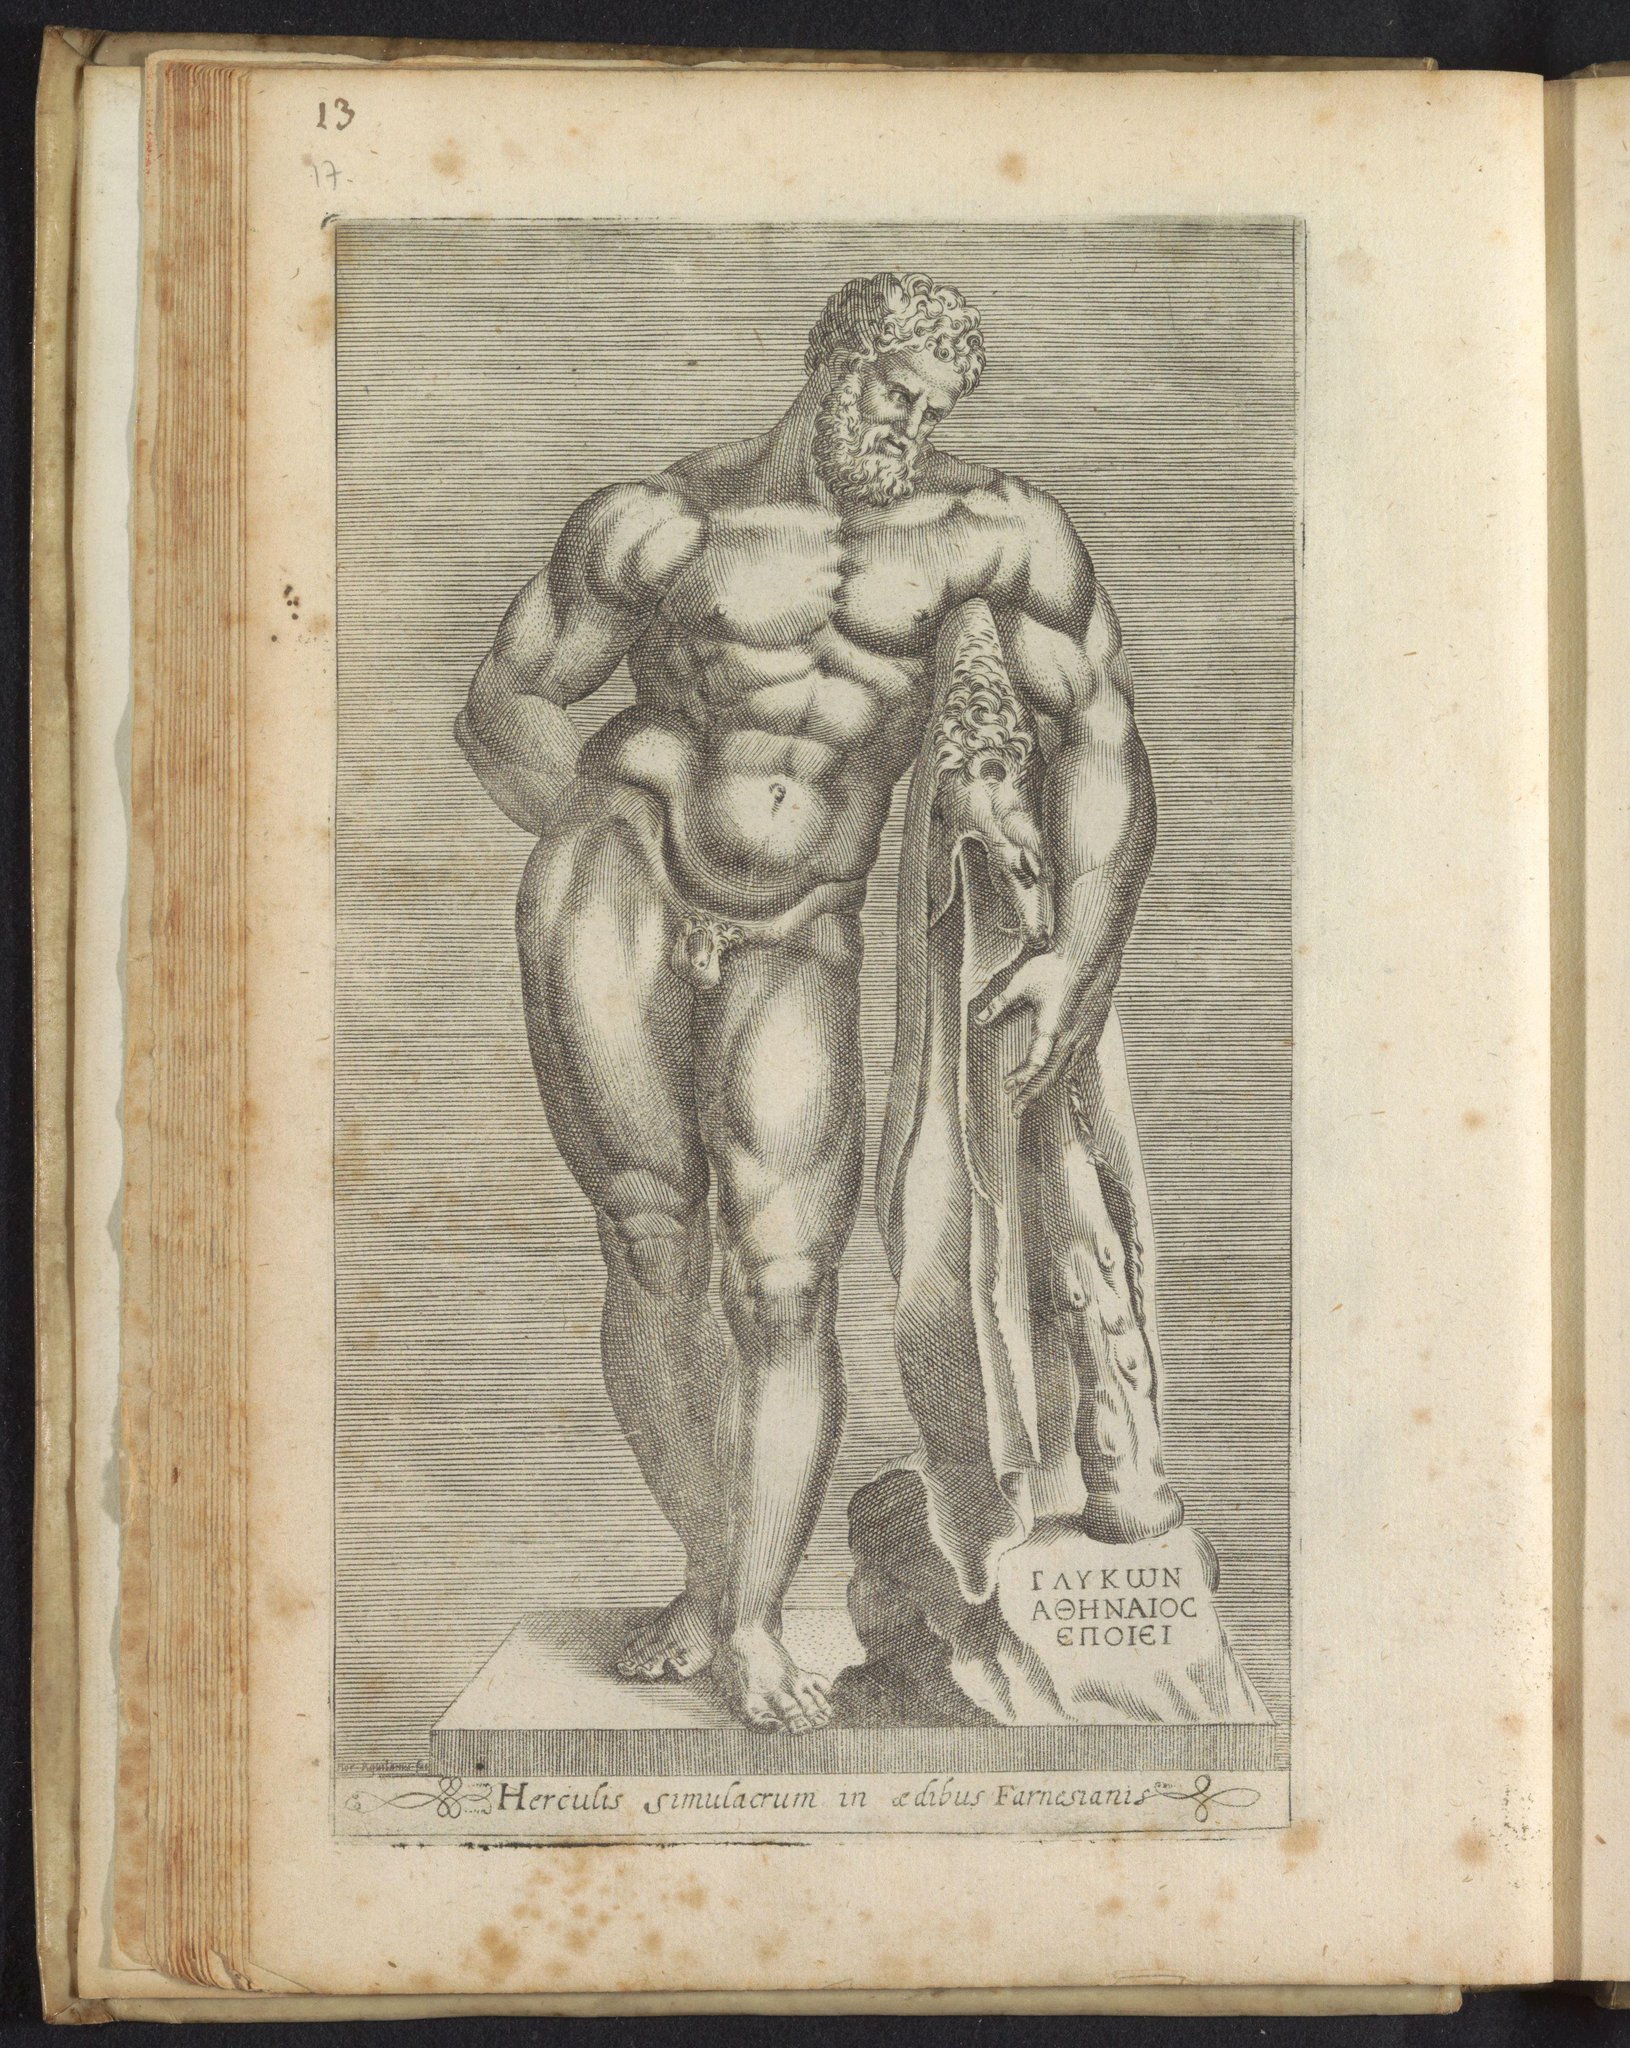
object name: print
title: Hercules Farnese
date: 1584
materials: paper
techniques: engraving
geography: italy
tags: (story of) hercules (heracles), piece of sculpture, reproduction of a piece of sculpture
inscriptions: number: ‘13’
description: Tot 1787 stond dit beeld in het Palazzo Farnese, vandaar de benaming Hercules Farnese. Deze prent maakt deel uit van een set van 79 prenten (+ titelprent) met voorstellingen van antieke sculpturen in Rome. Deze prent maakt deel uit van een set van 79 prenten (+ titelprent) met voorstellingen van antieke sculpturen in Rome.